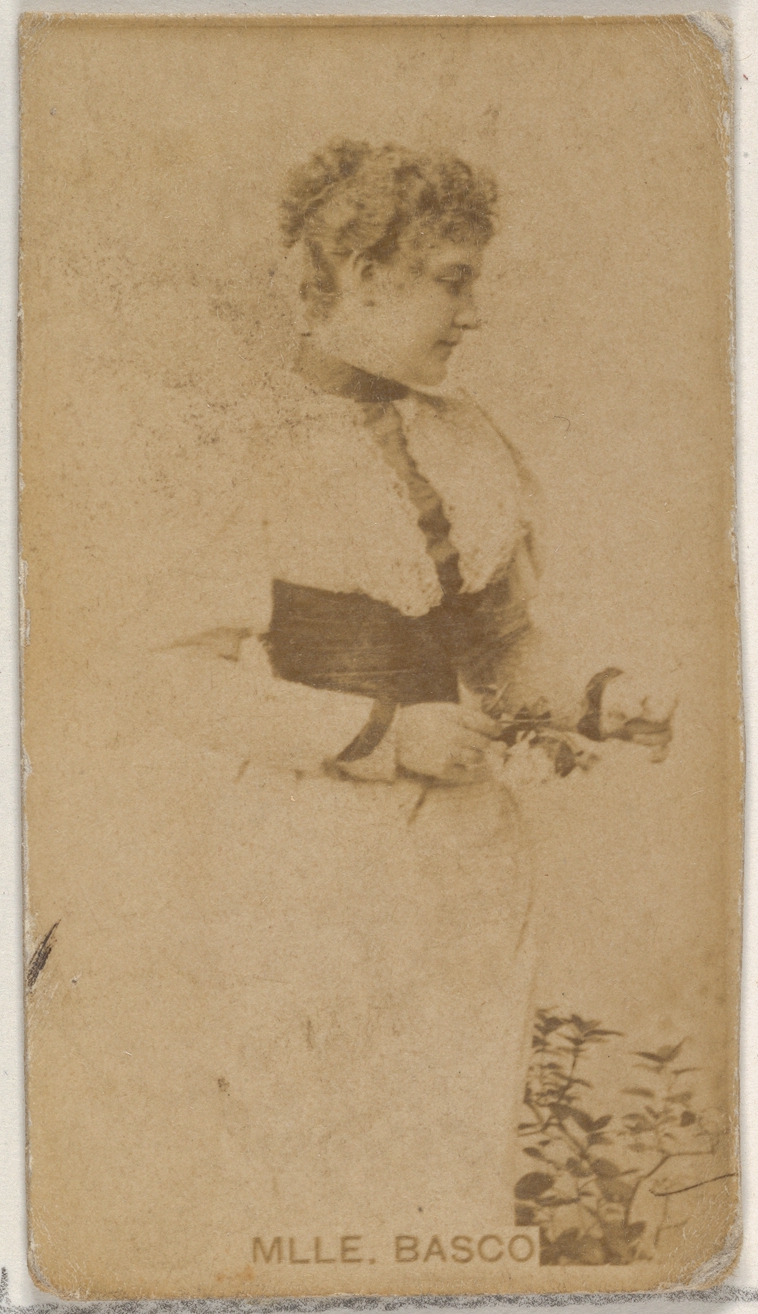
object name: photograph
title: Mlle. Basco, from the Actors and Actresses series (N45, Type 8) for Virginia Brights Cigarettes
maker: allen & ginter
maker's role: publisher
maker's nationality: american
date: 1888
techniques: albumen silver print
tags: portraits,women,actresses